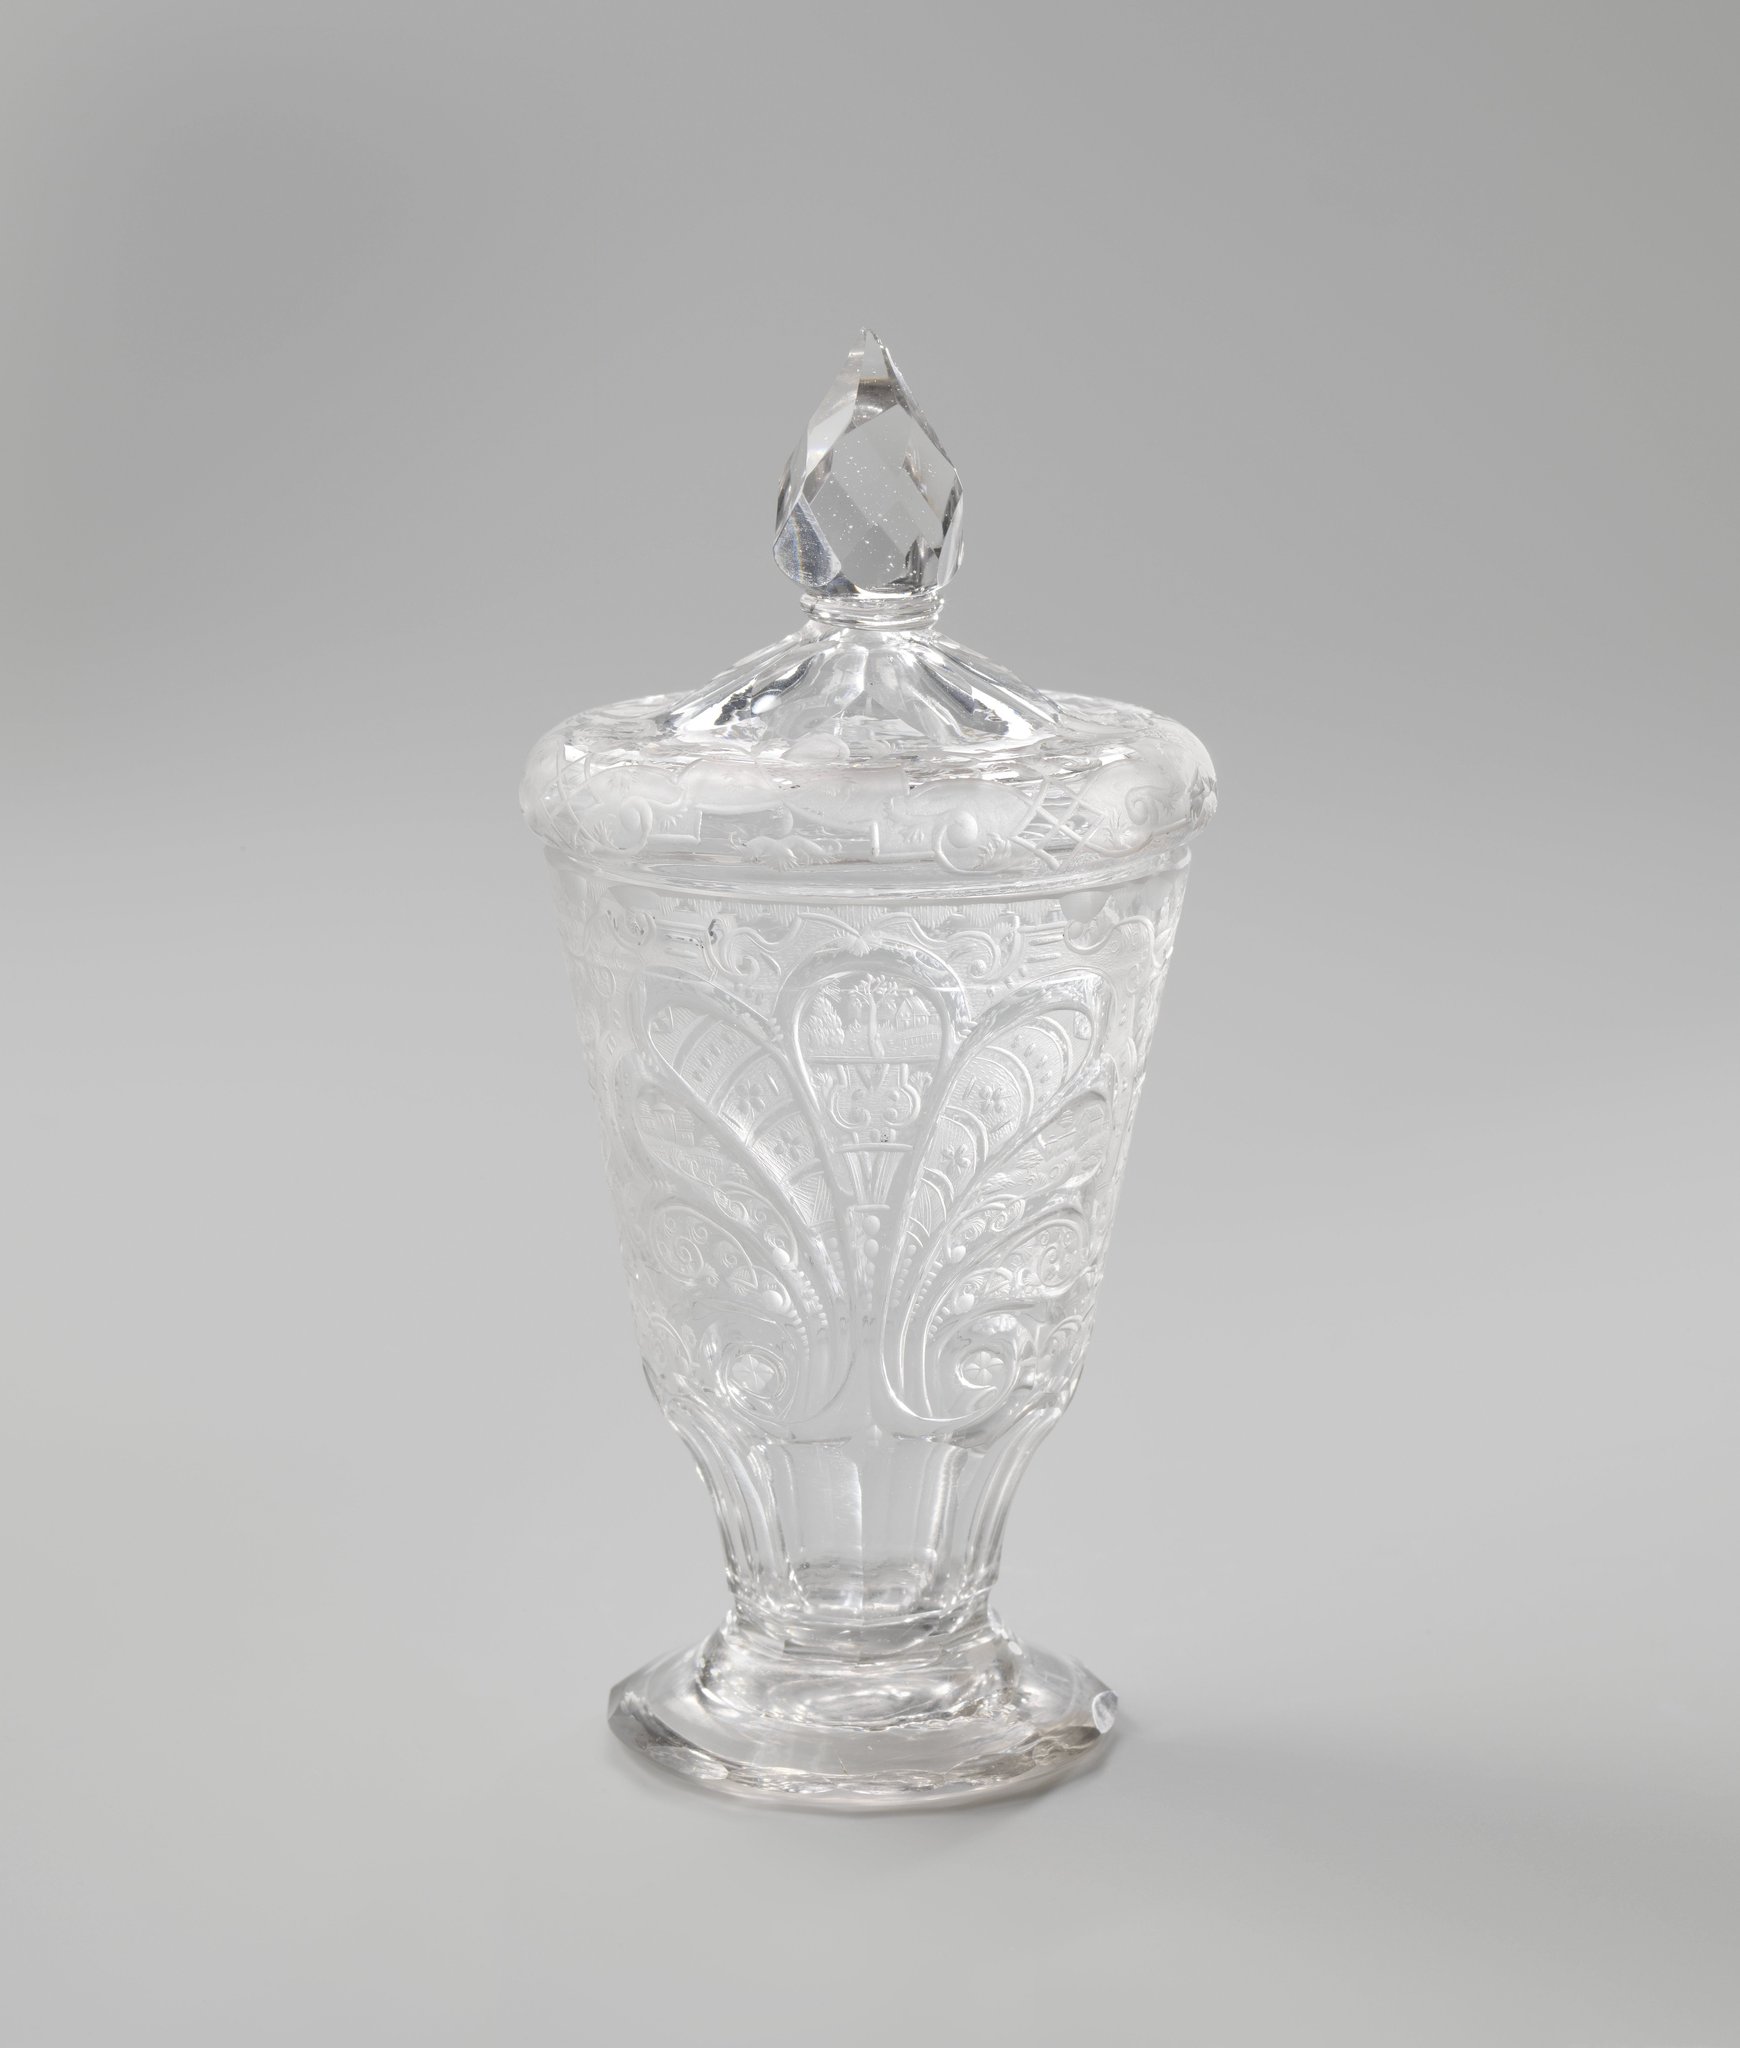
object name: standing cup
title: Lidded wine glass with the alliance arms of two German families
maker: Anonymous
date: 1725-1750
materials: glass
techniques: glassblowing, grinding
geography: silesia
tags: palmette ~ ornament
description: Kelkglas met deksel. Radgravure met twee wapens. Silezië, ca. 1725 - 1750.